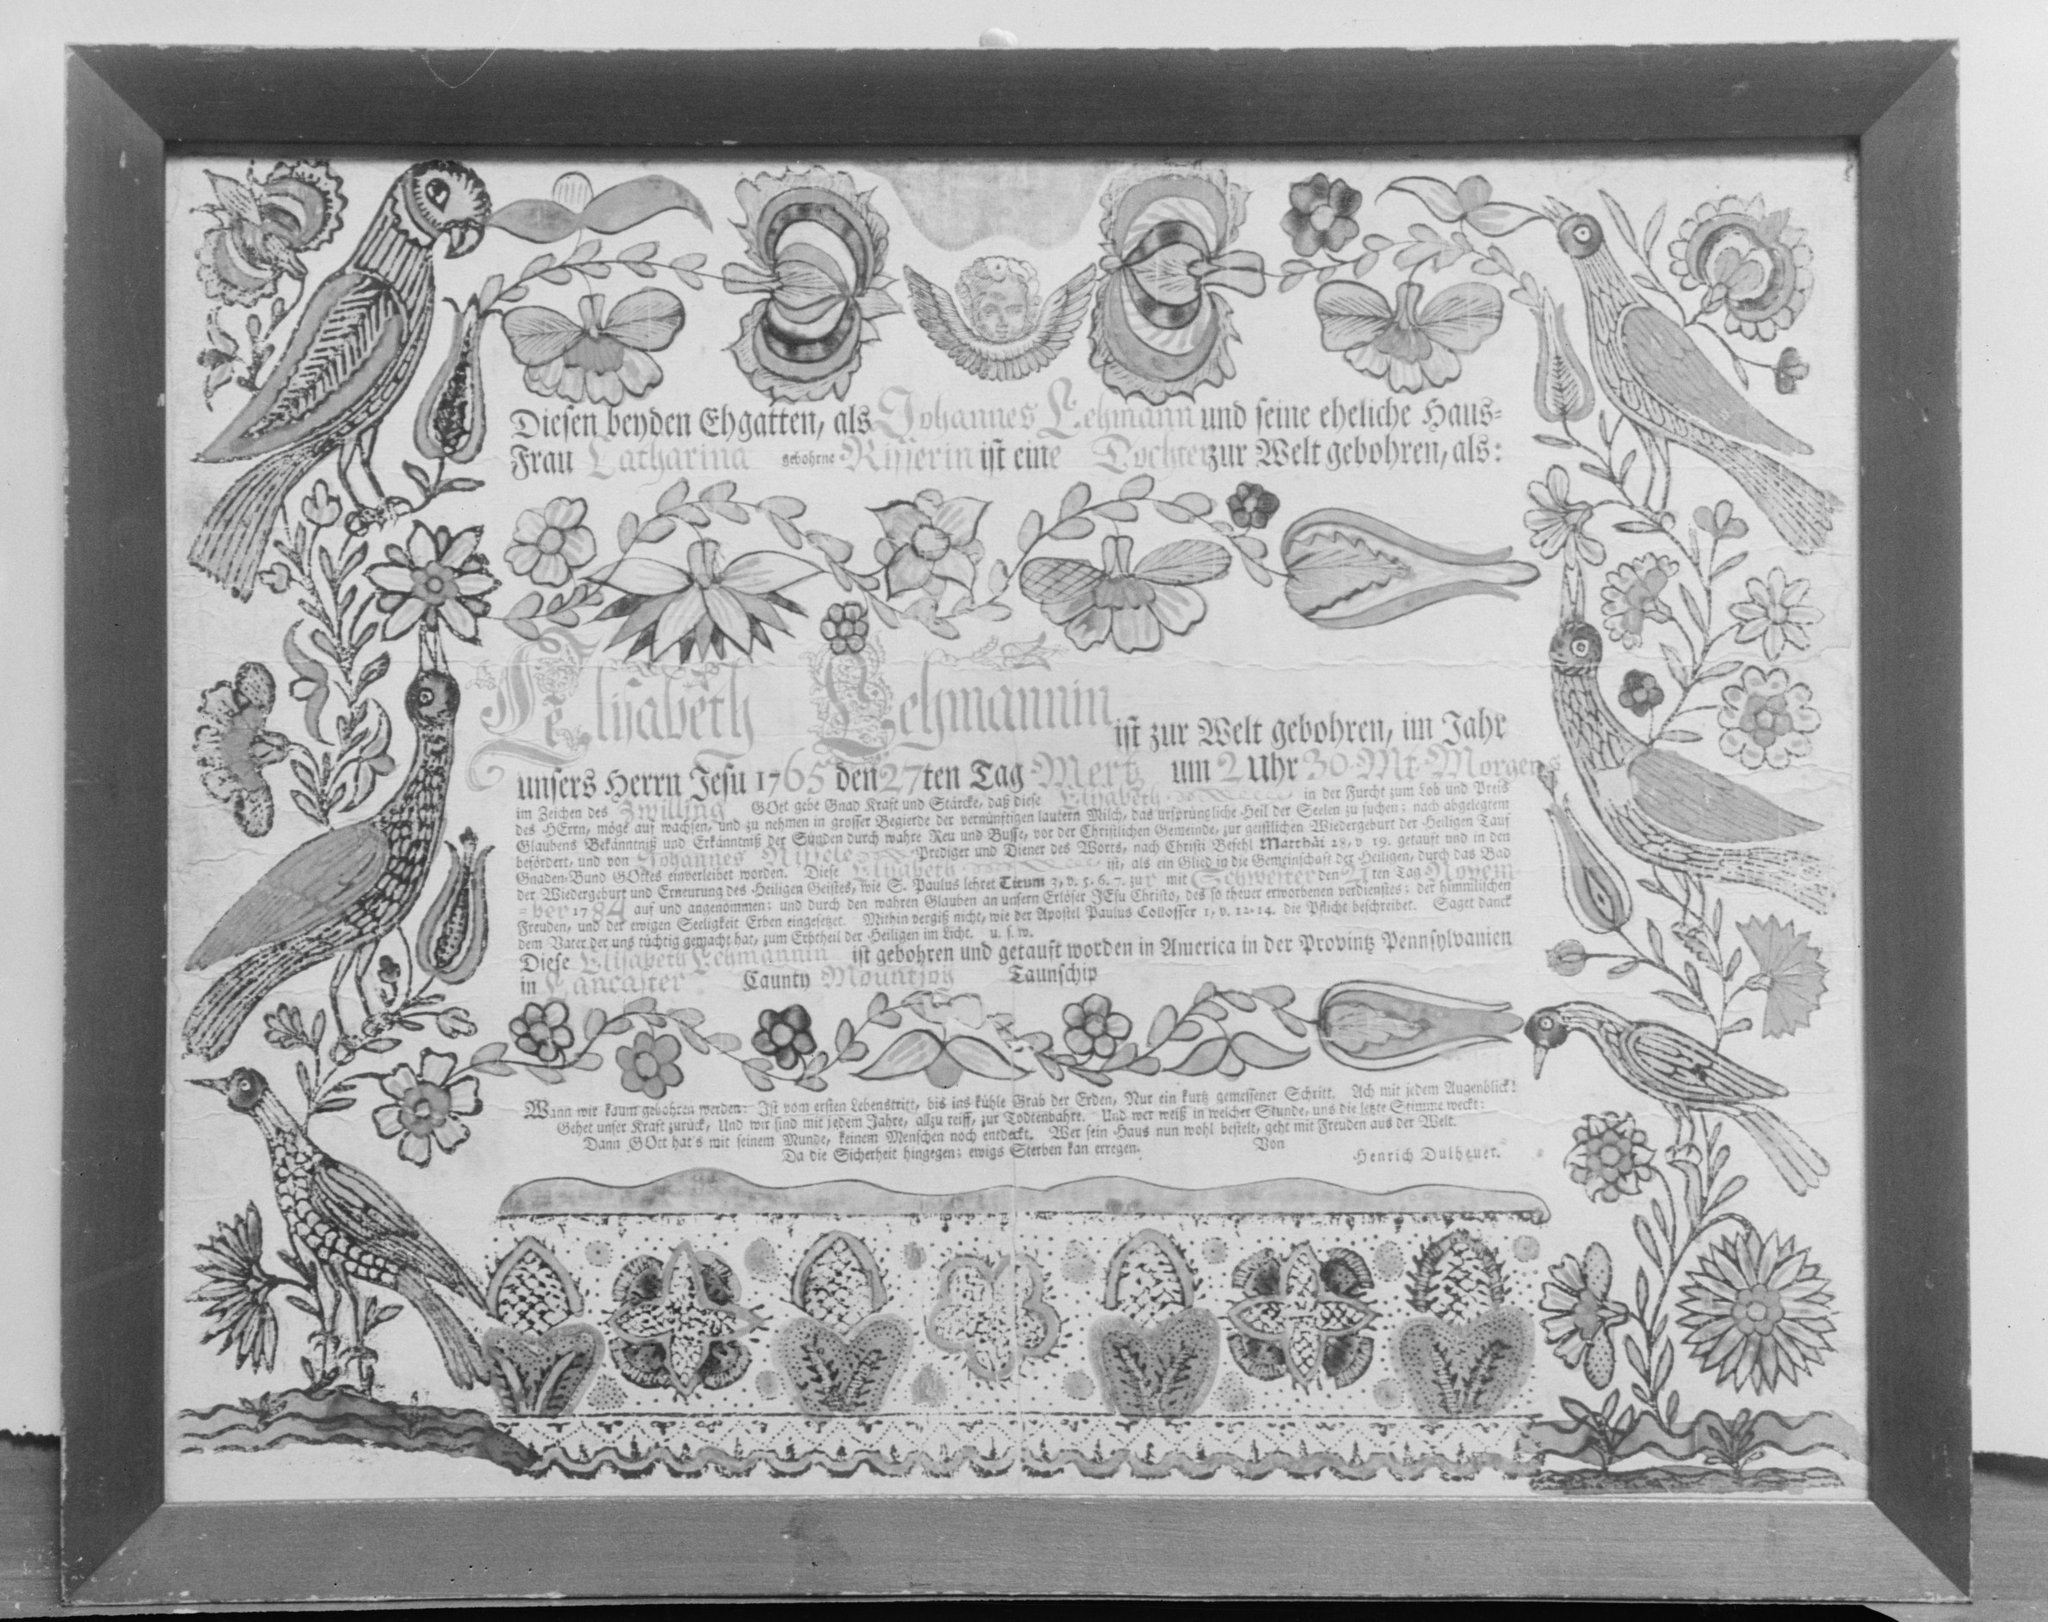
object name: birth and baptismal certificate, fraktur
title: Birth and Baptismal Certificate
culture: american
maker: henrich dulhauer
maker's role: maker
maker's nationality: american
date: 1784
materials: ink, paper, watercolor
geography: united states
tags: birds